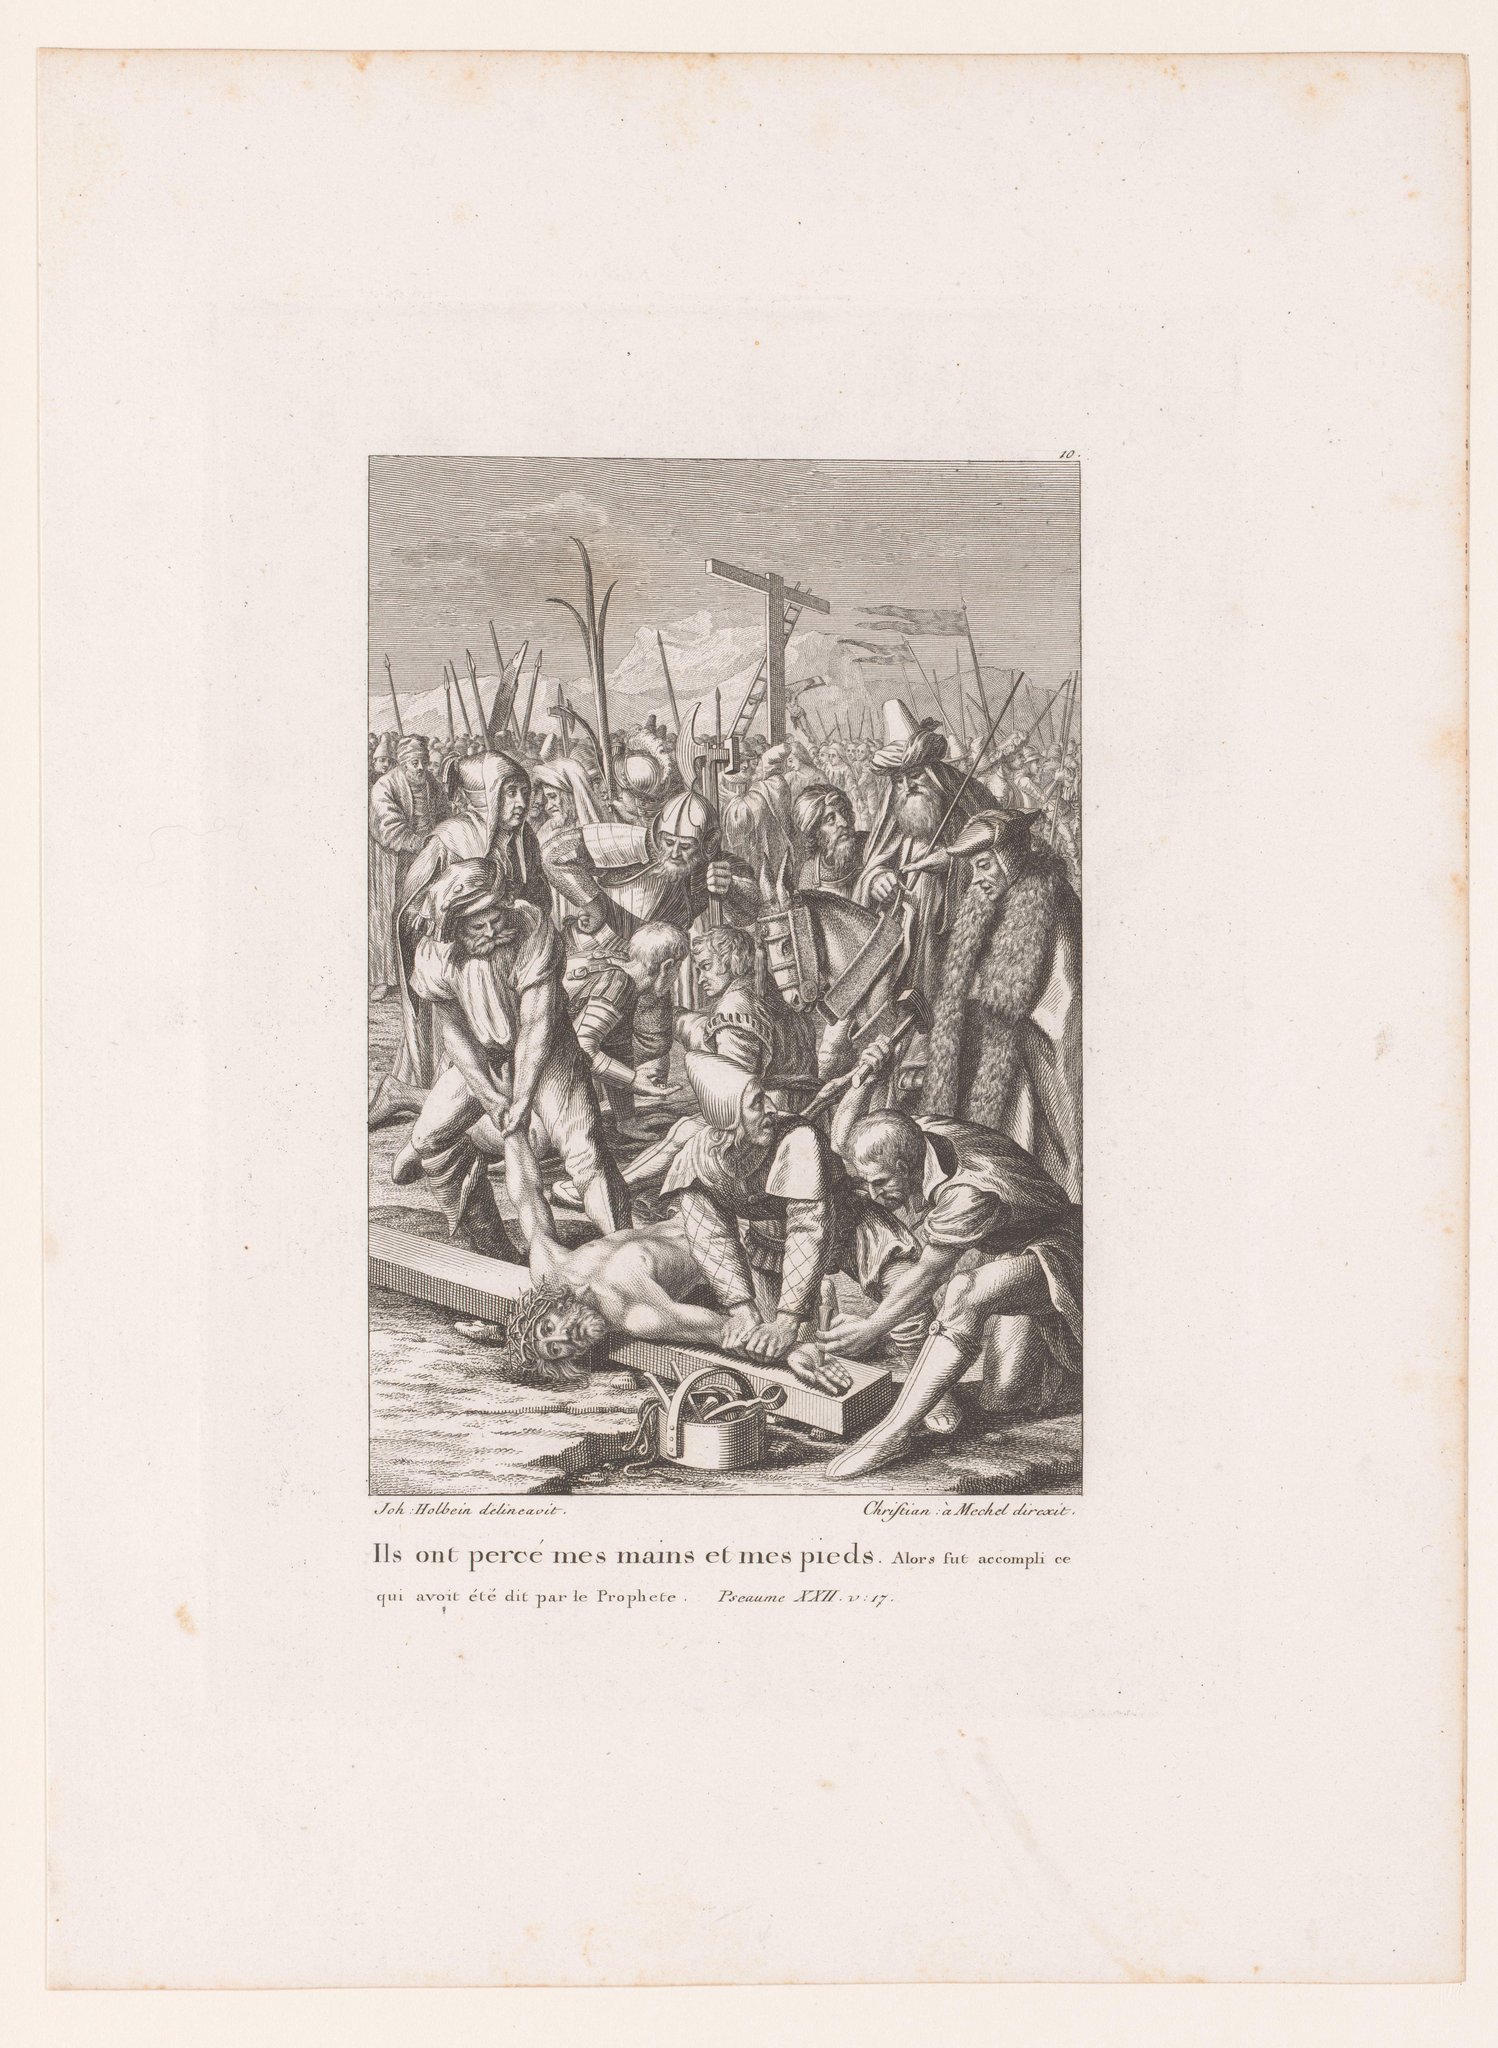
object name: print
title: Ils ont percé mes mains et mes pieds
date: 1784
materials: paper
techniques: etching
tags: soldiers casting lots for or quarrelling over christ's seamless garment, the erection of the cross: christ is nailed to the cross which lies on the ground, mountain-range, snow peaks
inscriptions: collector's mark: Lugt 2228, collector's mark: Lugt 4404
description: De serie is deel twee van de vier-delige publicatie 'Oeuvre de Jean Holbein', Bazel 1780-1795, door Christian von Mechel.